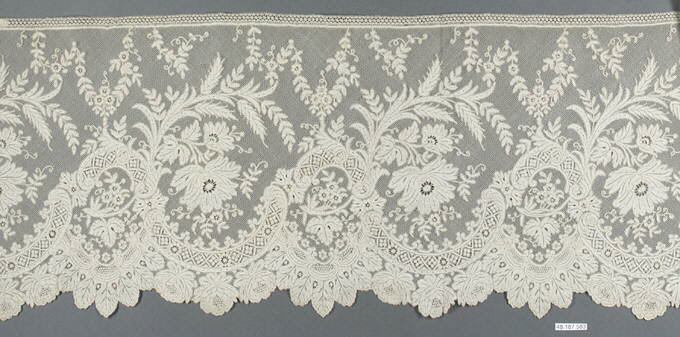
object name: border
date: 1851-1900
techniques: lace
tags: flowers